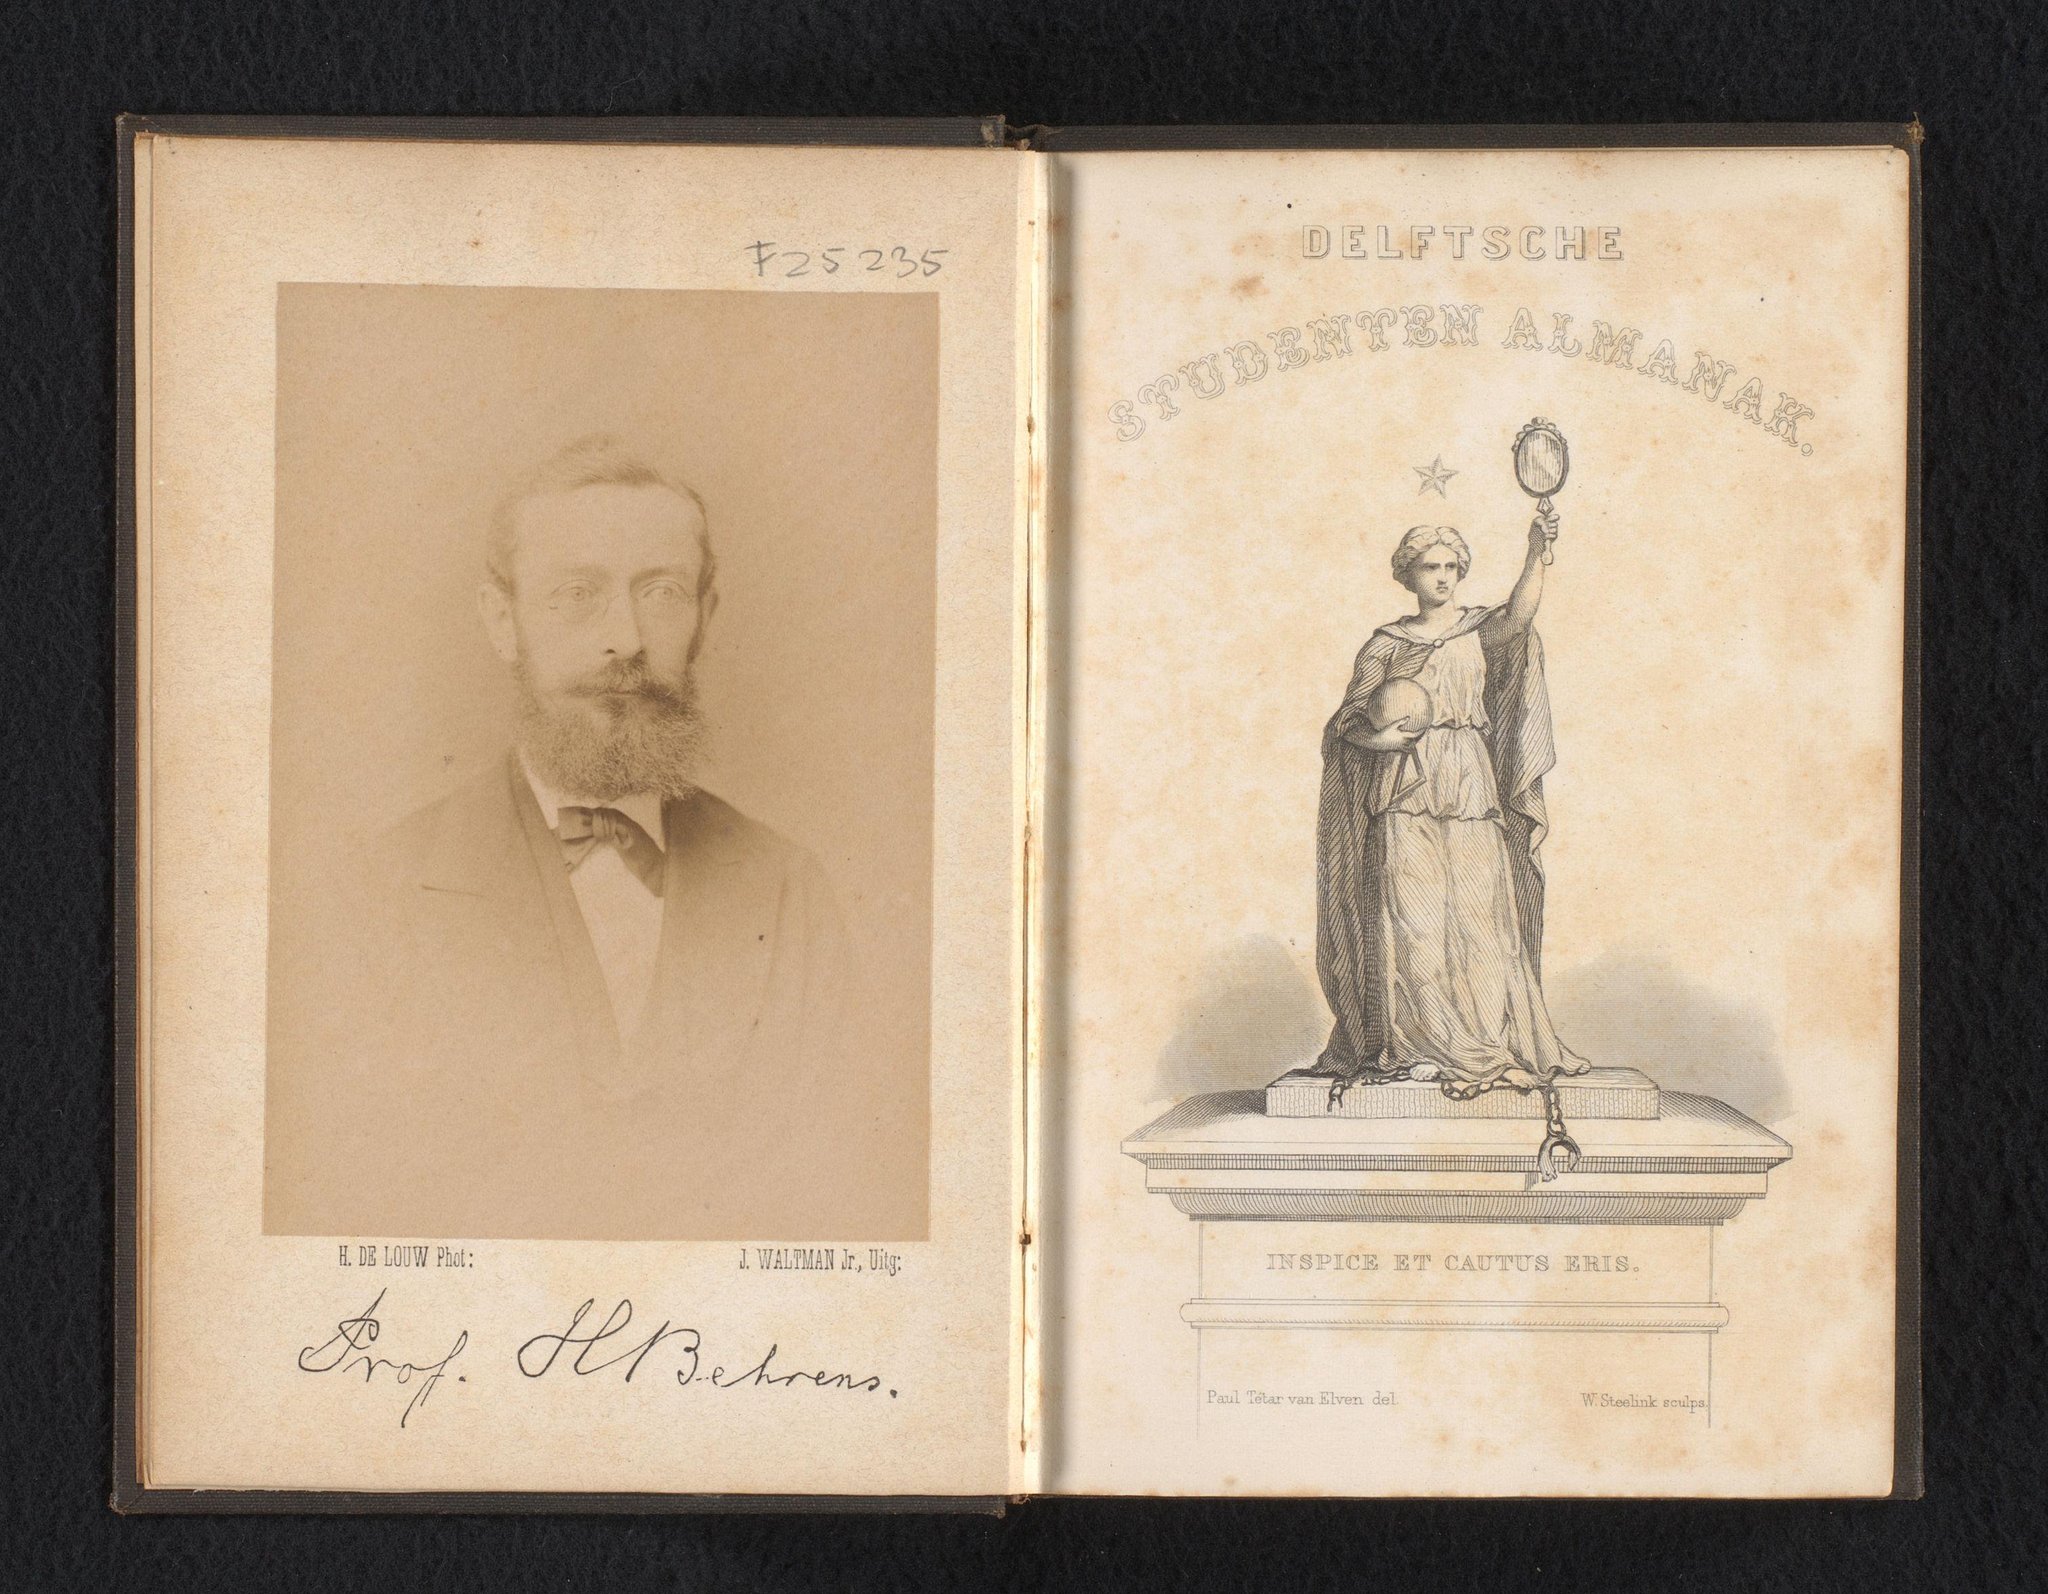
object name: page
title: Portret van T.H. Behrens, hoogleraar in de mineralogie, geologie en het mijnwezen aan de Polytechnische School Delft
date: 1881-1882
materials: paper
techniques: albumen print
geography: delft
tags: historical persons, professor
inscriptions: signature: ‘Prof. H Behrens’